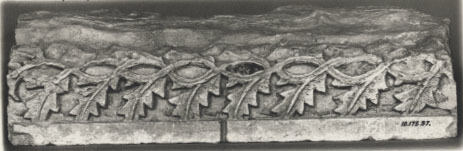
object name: fragment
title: Fragment of Molding with a Leaves Pattern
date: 501-700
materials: limestone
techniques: carving, relief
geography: egypt